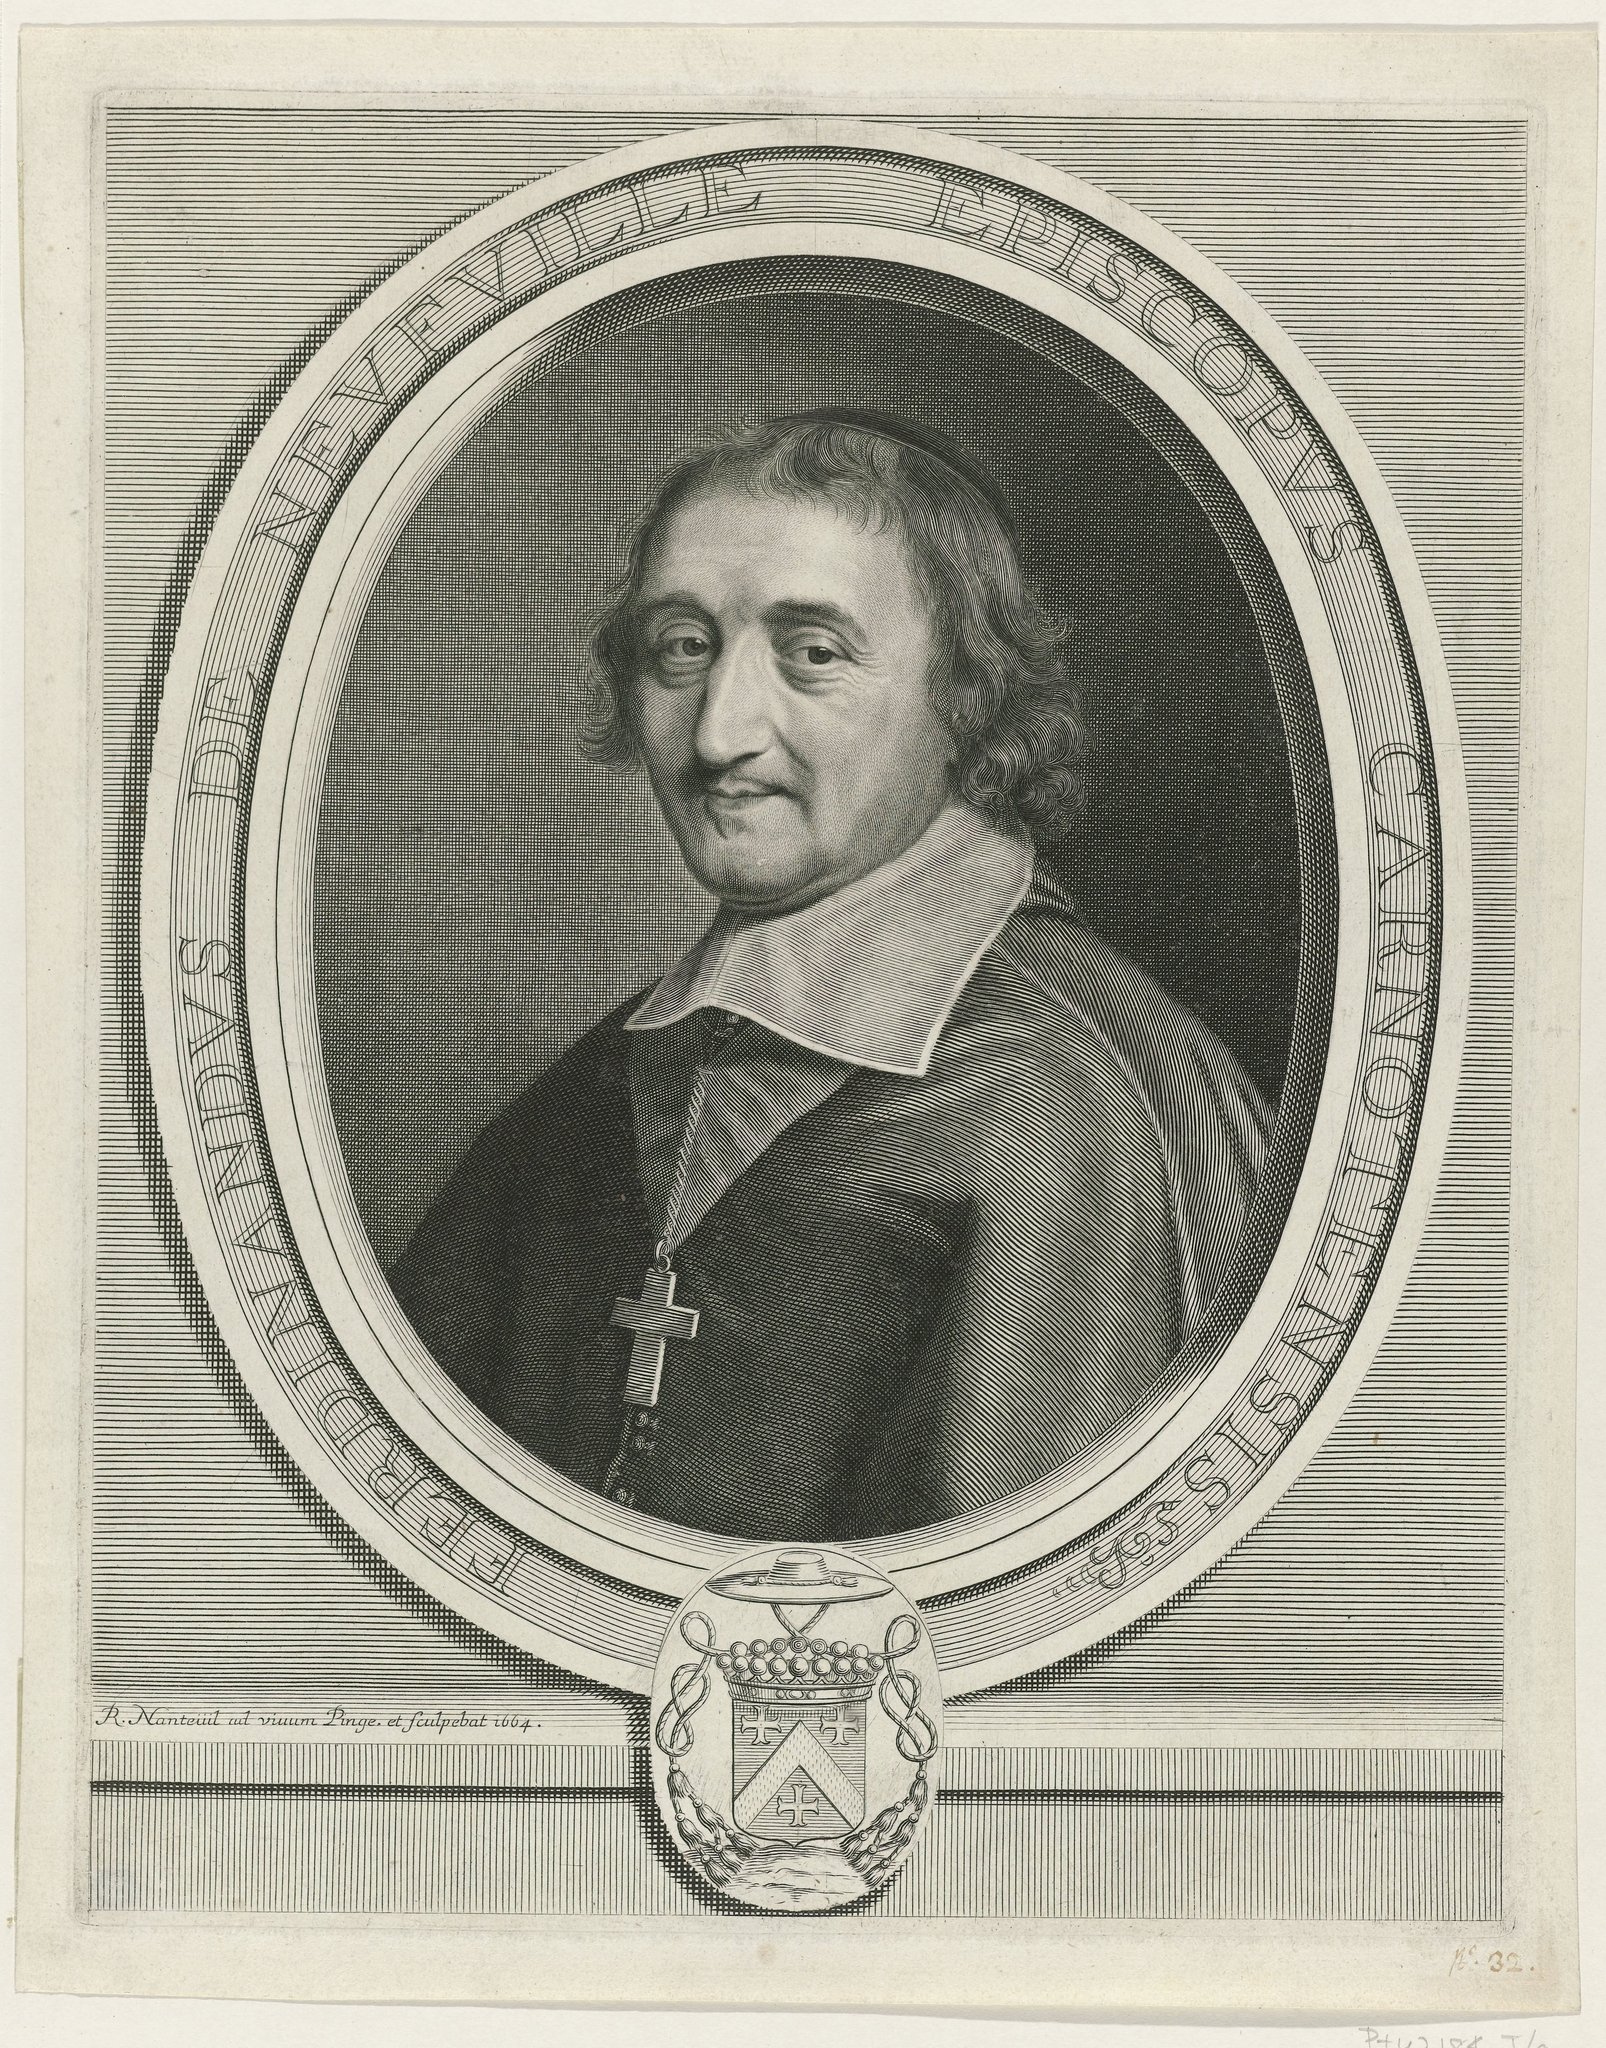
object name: print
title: Portret Ferdinand de Neufville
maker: robert nanteuil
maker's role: print maker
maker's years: 1623-1678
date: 1664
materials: paper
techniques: engraving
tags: clergyman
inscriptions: date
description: Buste naar links, in ovale lijst met randschrift. Wapen middenonder.